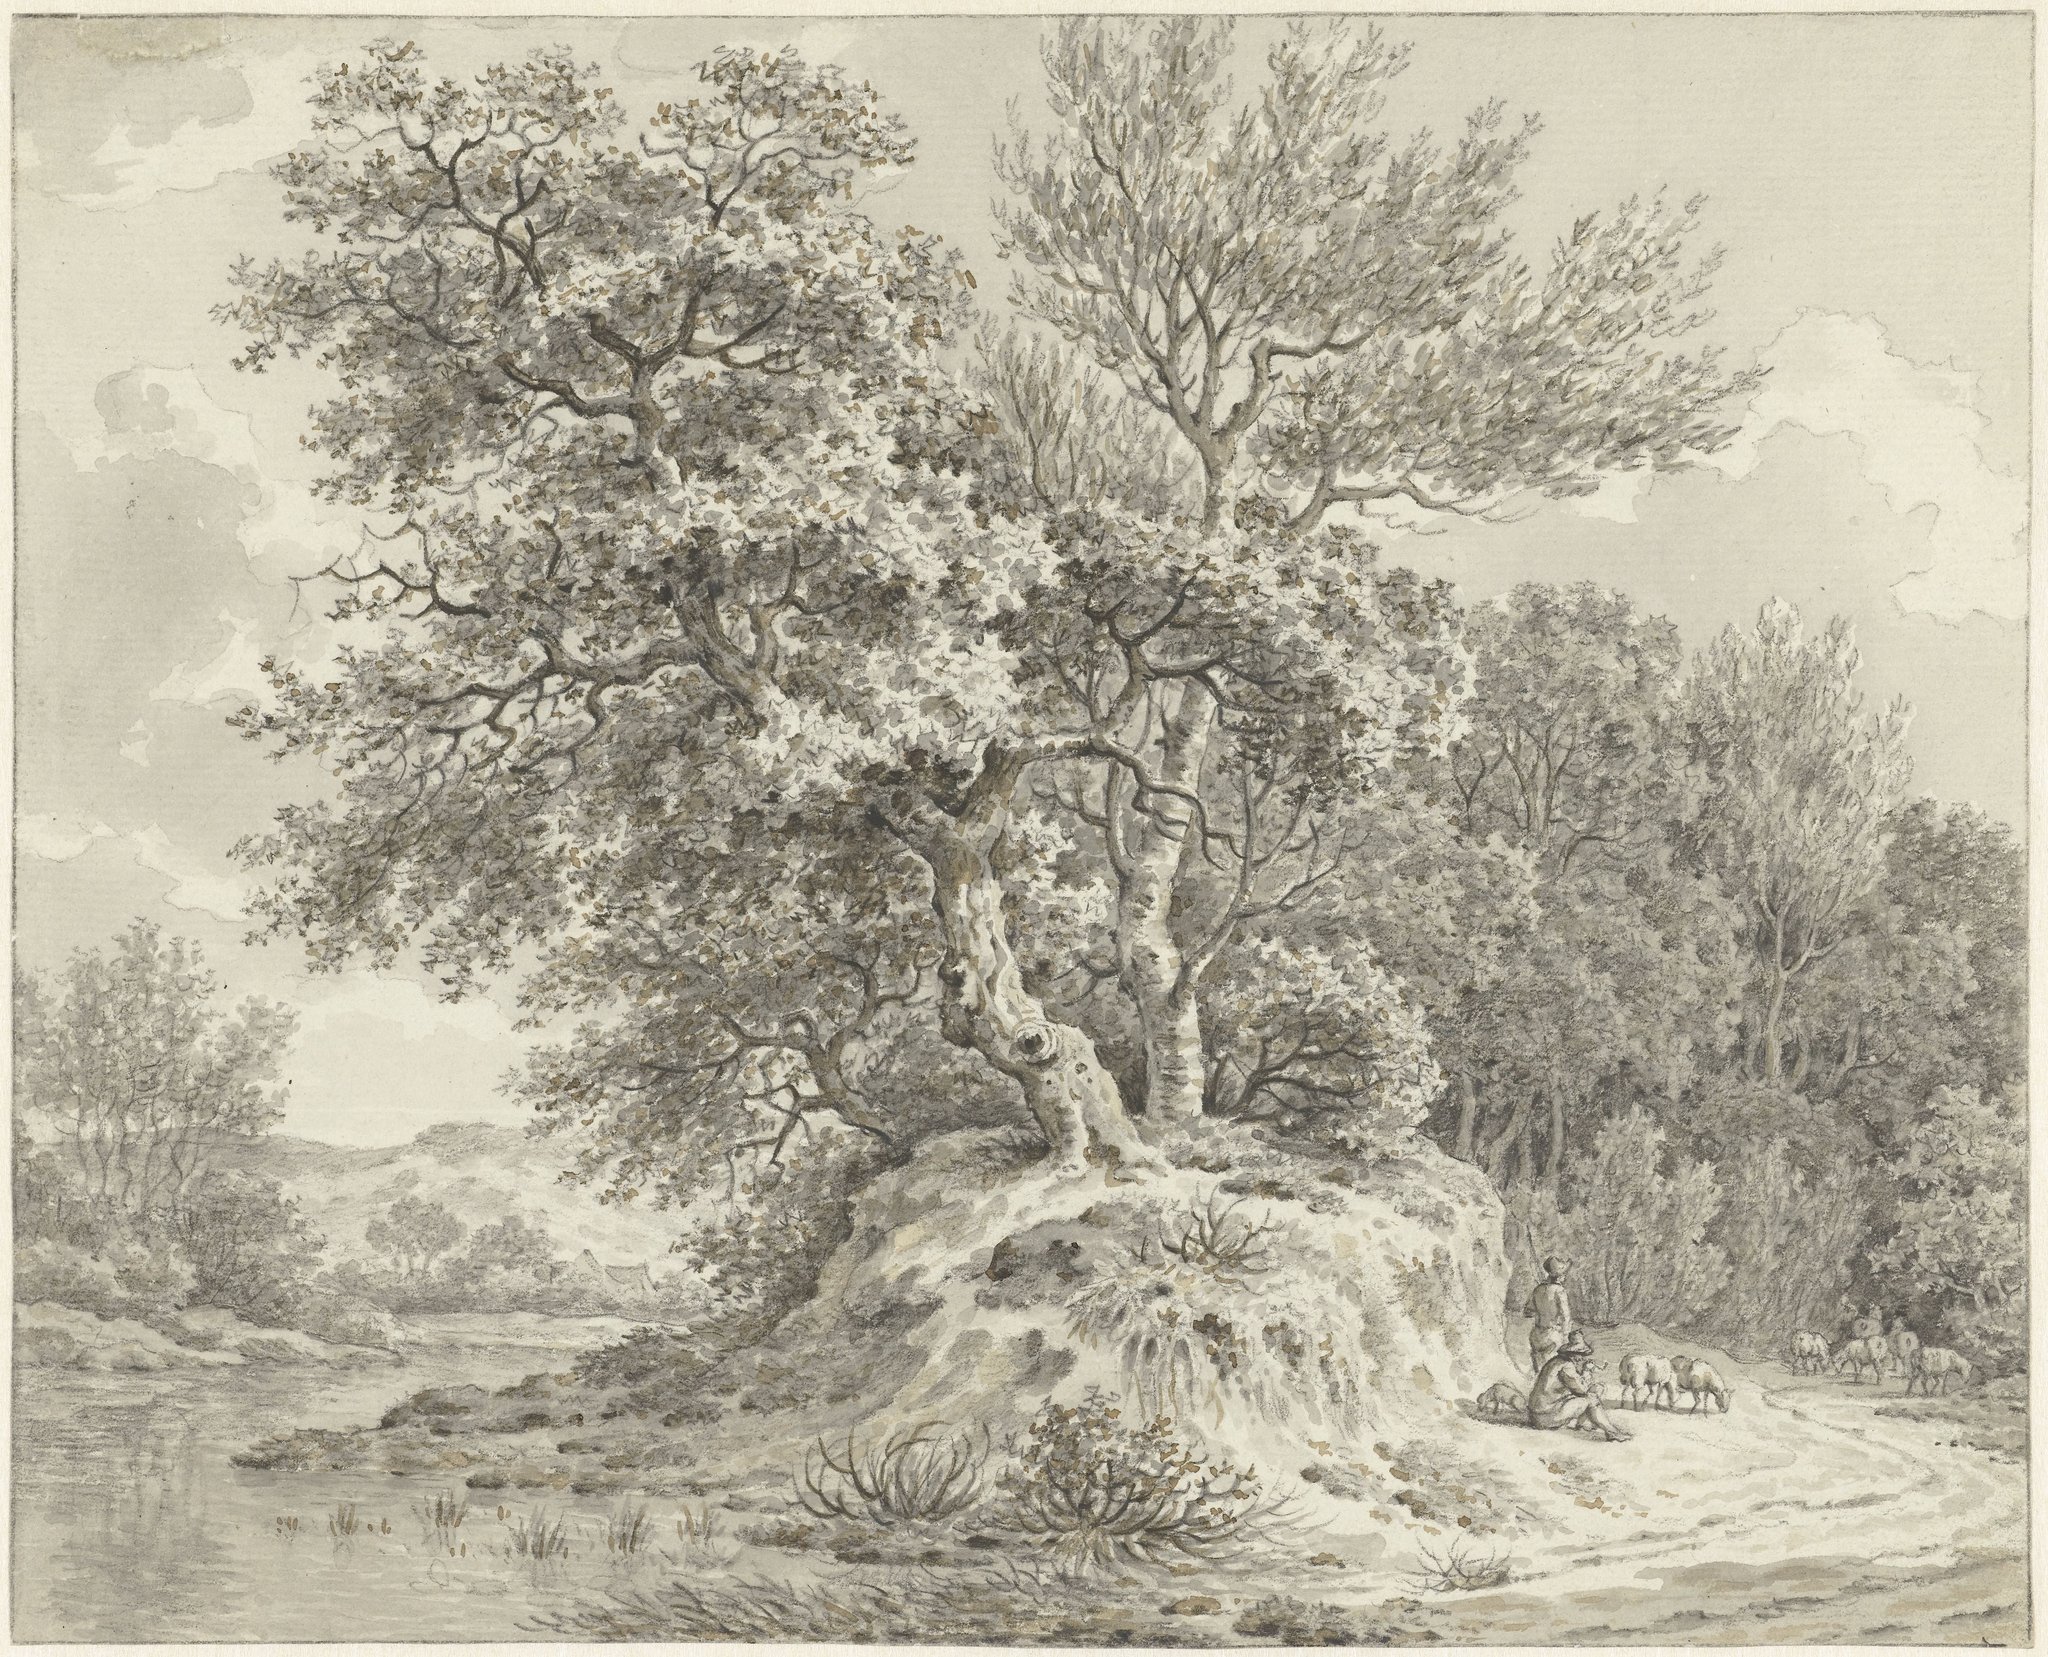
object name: drawing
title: Landschap bij Alkmaar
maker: jan evert grave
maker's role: draughtsman, print maker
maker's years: 1759-1805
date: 1769-1805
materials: chalk, paper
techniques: brush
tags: landscapes in the temperate zone